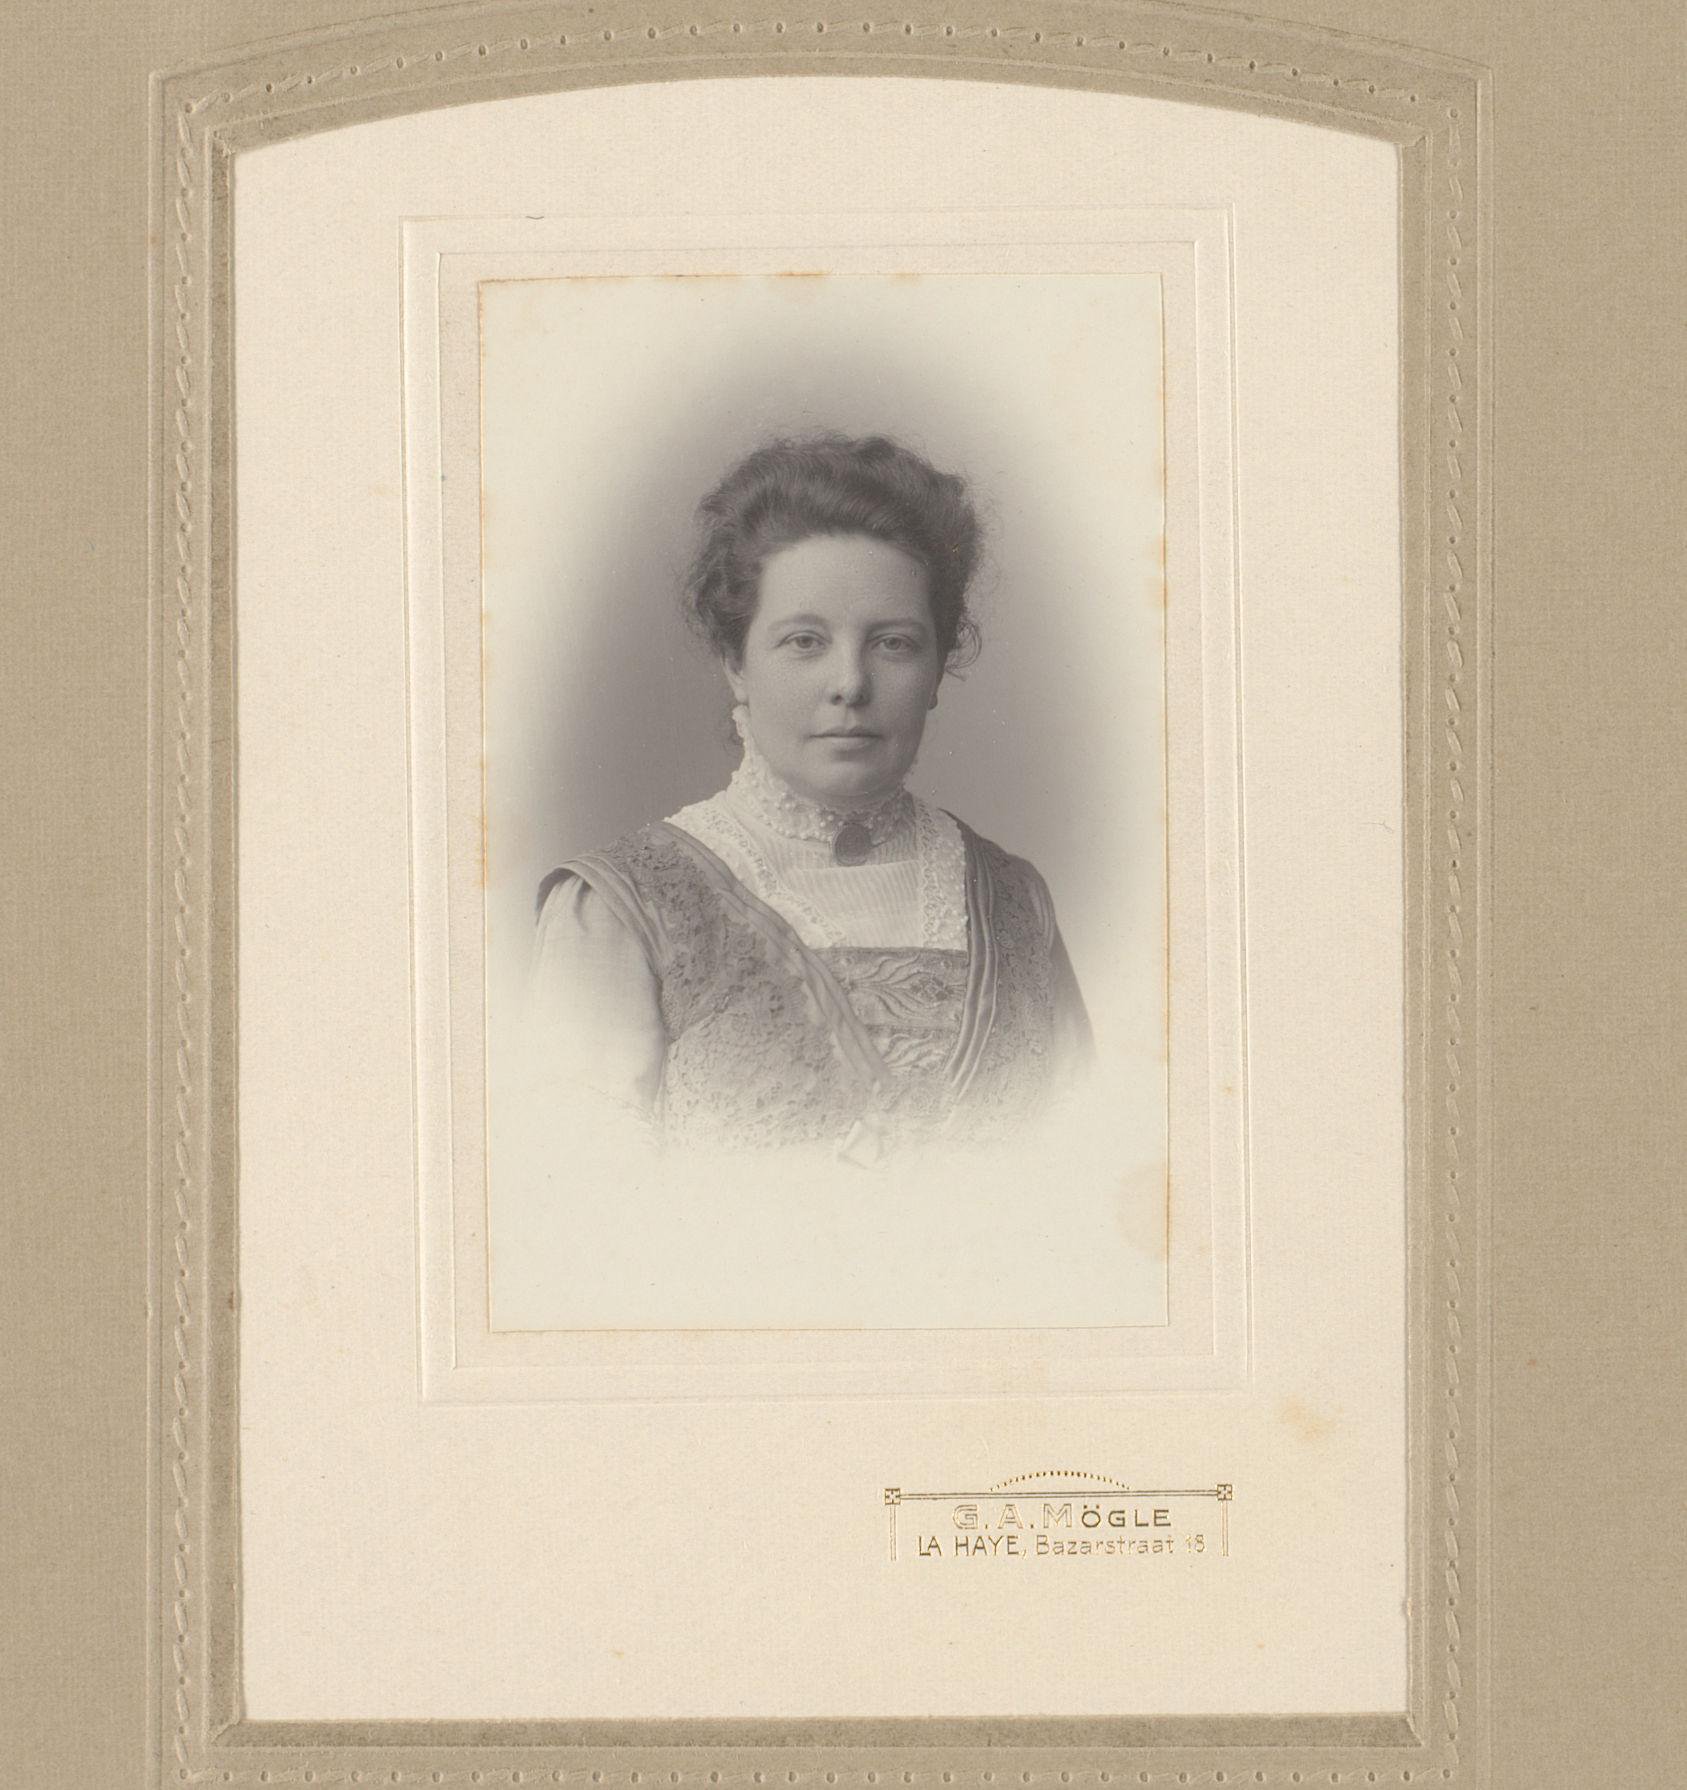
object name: photograph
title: Portret van een vrouw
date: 1900-1910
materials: paper, photographic support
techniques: gelatin silver print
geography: netherlands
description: Onderdeel van overdracht foto's en albums van familie Kessler-de Lange.